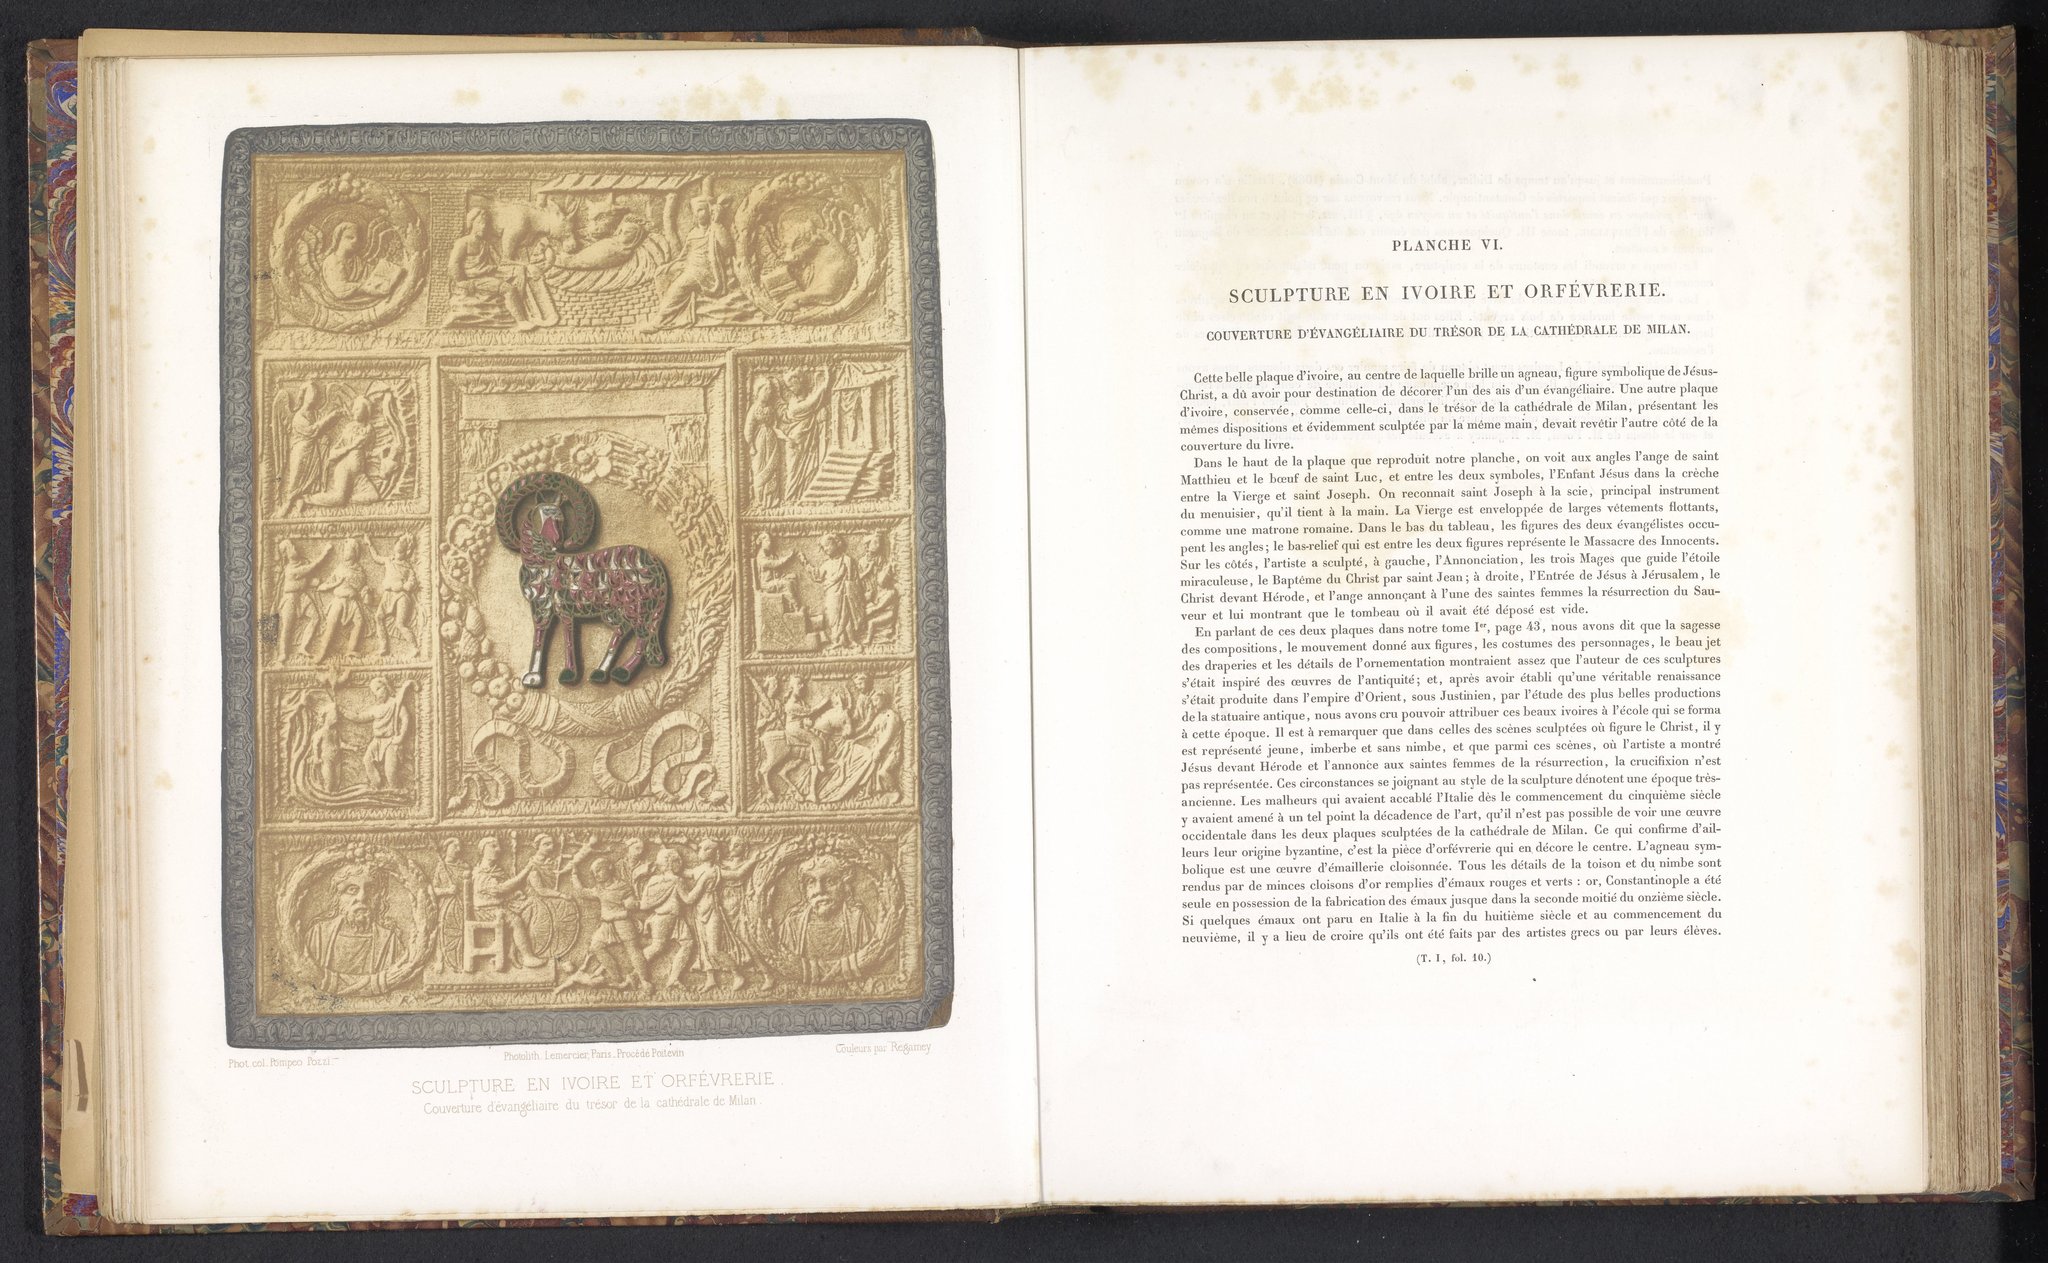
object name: photomechanical print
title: Ivoren blad van een evangeliarium met een reliëf, voorstellende het Lam Gods en scènes uit het Nieuwe Testament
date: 1859-1864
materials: paper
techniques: photolithography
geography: paris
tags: lamb bearing cross or banner, 'agnus dei' ~ symbol of christ, new testament, sculpture (+ relief ~ sculpture)